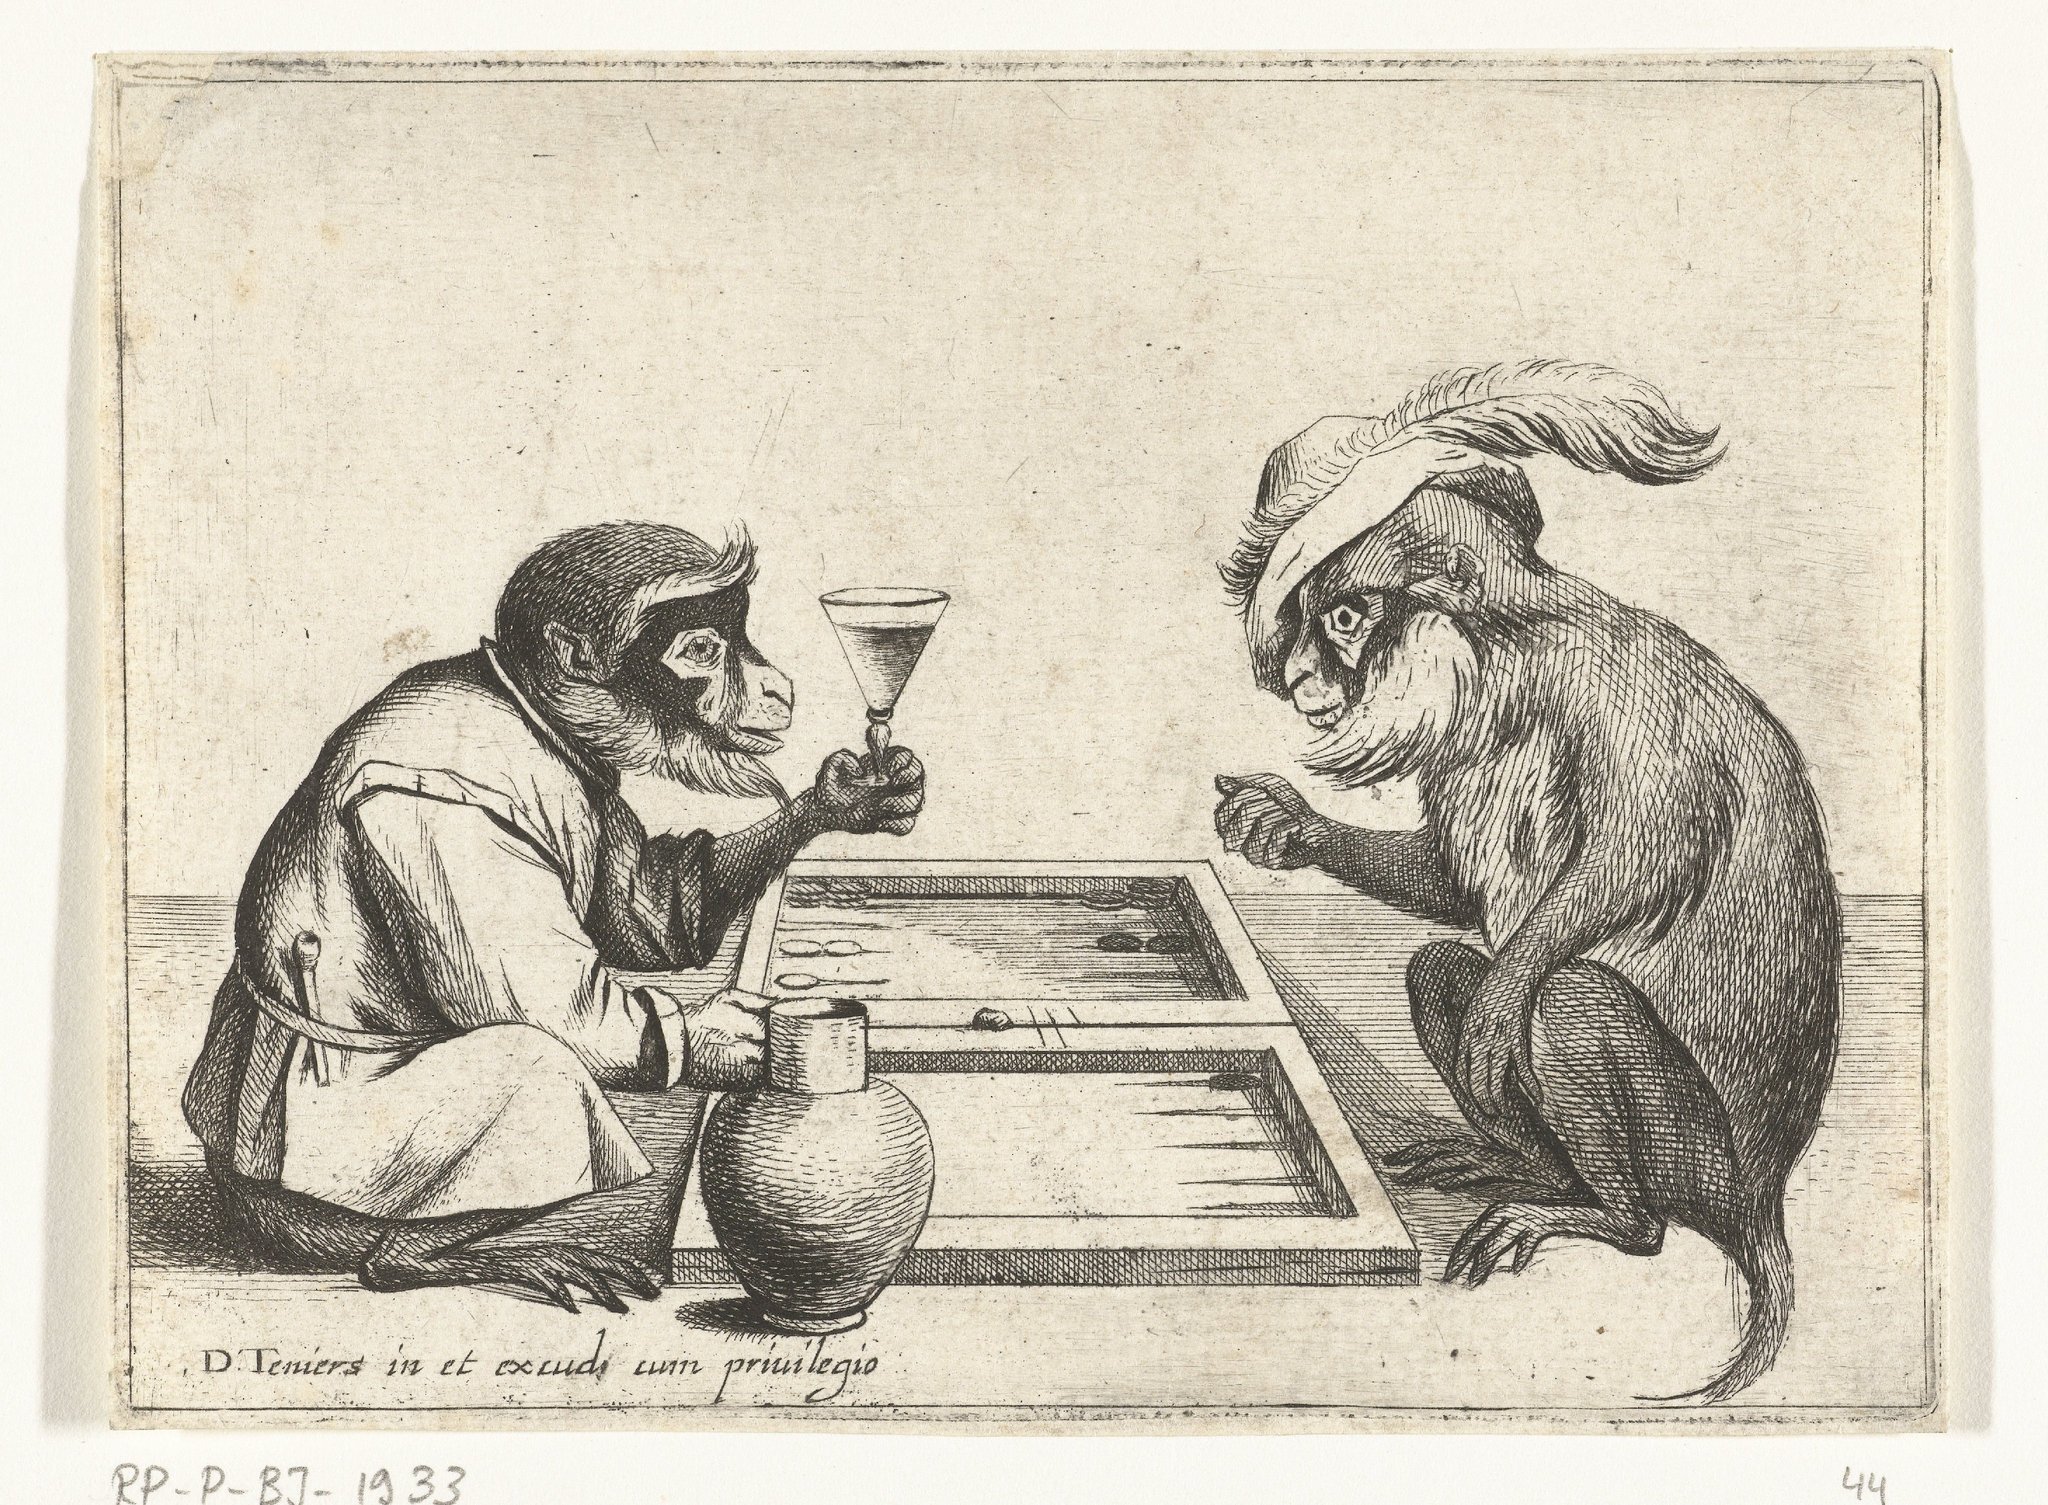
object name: print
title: Verschillende bedrijven uit het menselijke leven door apen voorgesteld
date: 1635-1690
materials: paper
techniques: etching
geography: southern netherlands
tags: monkeys, apes, animals acting as human beings, backgammon, tric-trac, glass of wine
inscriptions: collector's mark: Lugt 240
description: Twee apen zitten op de grond naast een triktrakspel. De rechtse draagt een hoed met een hanenveer, de linkse drinkt wijn uit een glas. Prent uit een serie van zes prenten en een titelprent waarin verschillende menselijke bezigheden door apen voorgesteld worden.